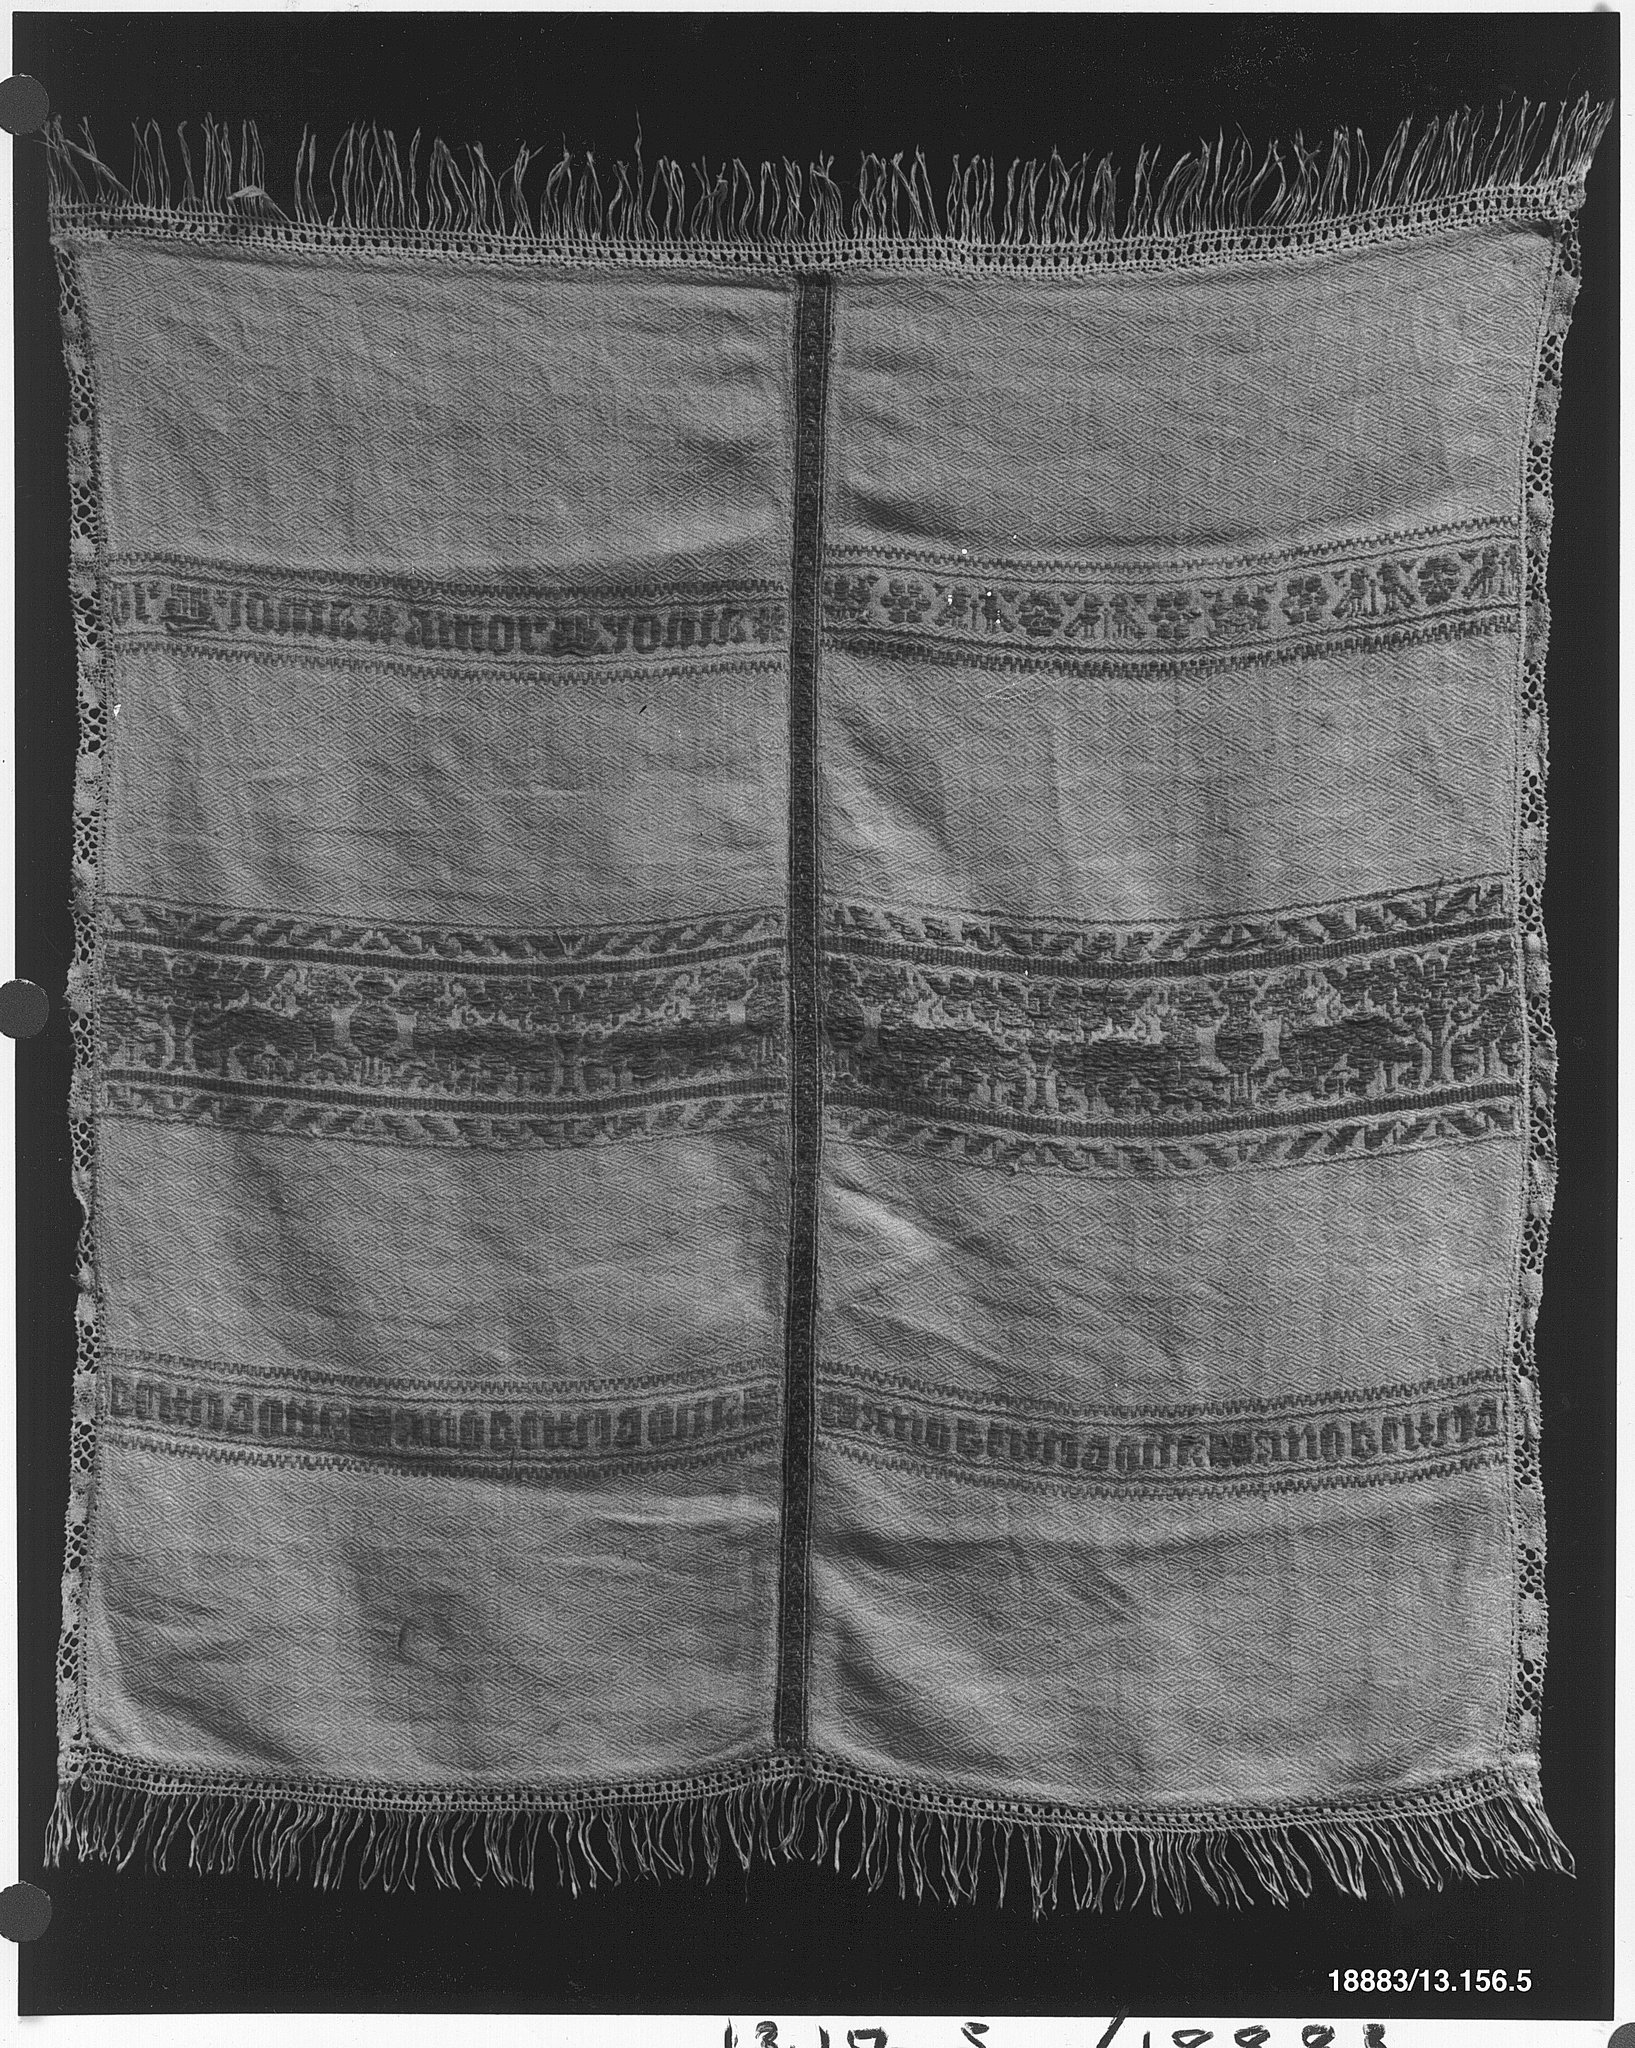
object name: cover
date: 1501-1700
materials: cotton, linen